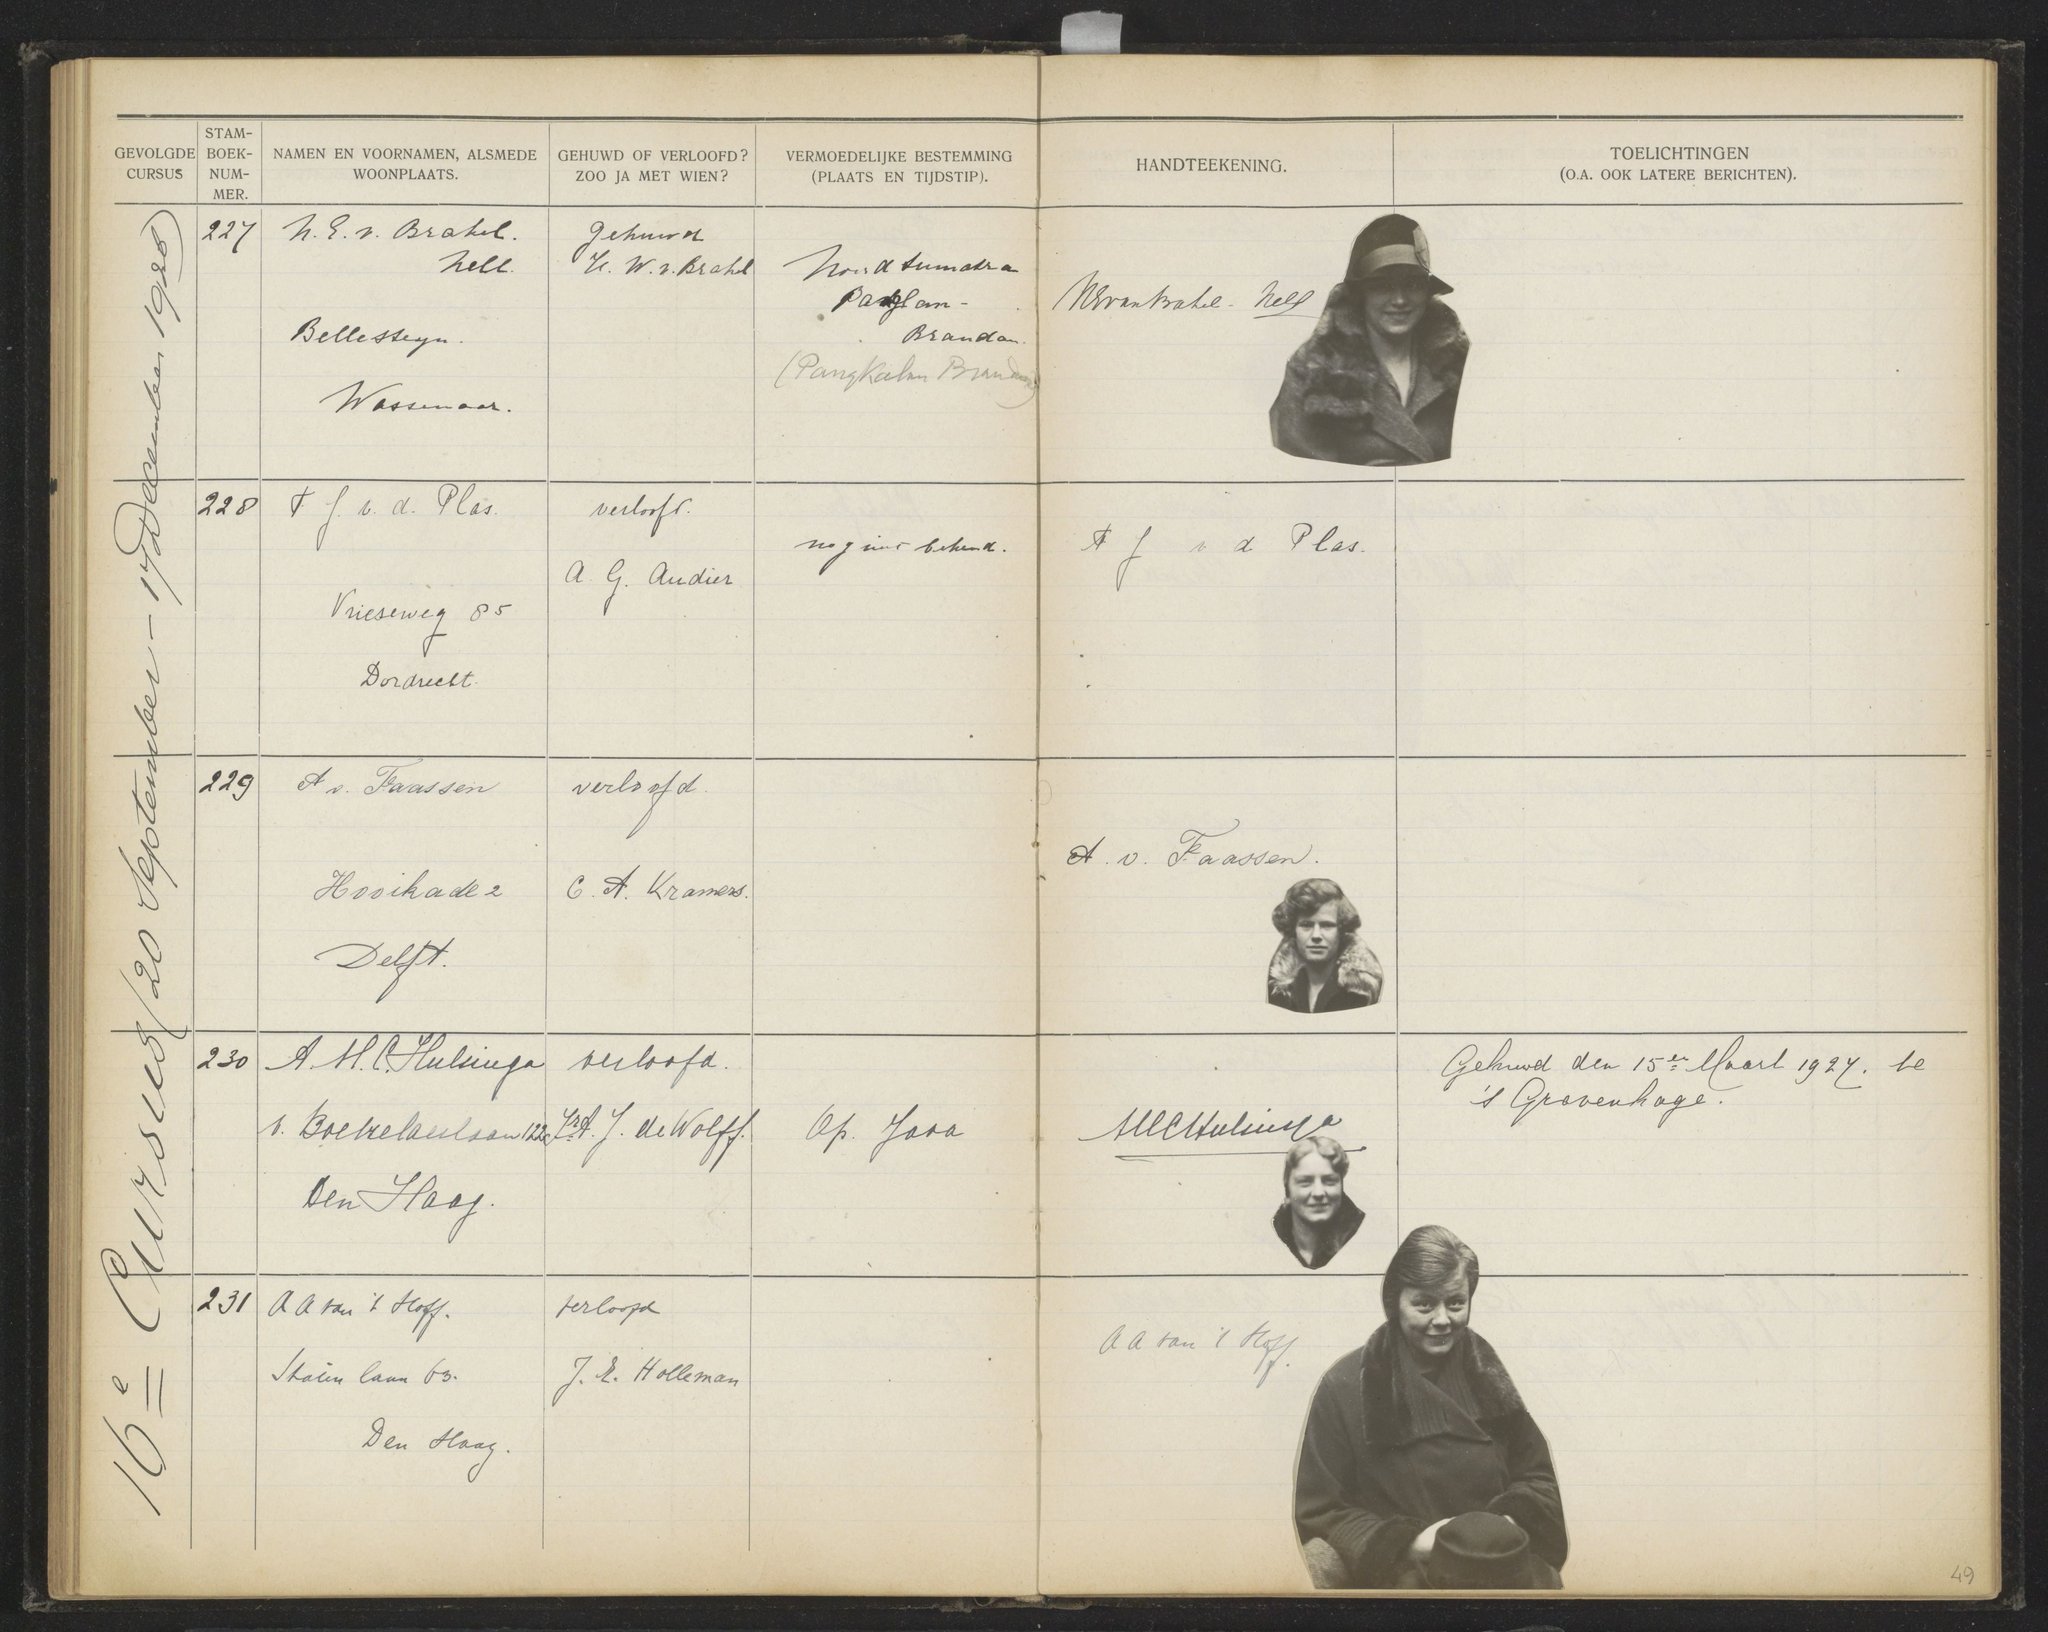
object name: photograph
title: Blad 49 uit Stamboek van de leerlingen der Koloniale School voor Meisjes en Vrouwen te 's-Gravenhage deel I (1921-1929)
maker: Anonymous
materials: paper, photographic support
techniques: photography, printing, writing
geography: the hague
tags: further education (+ pupil), further education, the hague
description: Twee pagina's met gegevens van de deelnemers aan de 16e driemaandelijkse cursus van 20 september tot en met 17 december 1926, stamboeknummers 227 tot en met 231. Onderdeel van Stamboek van de leerlingen der Koloniale School voor Meisjes en Vrouwen te 's-Gravenhage deel I (1921-1929).